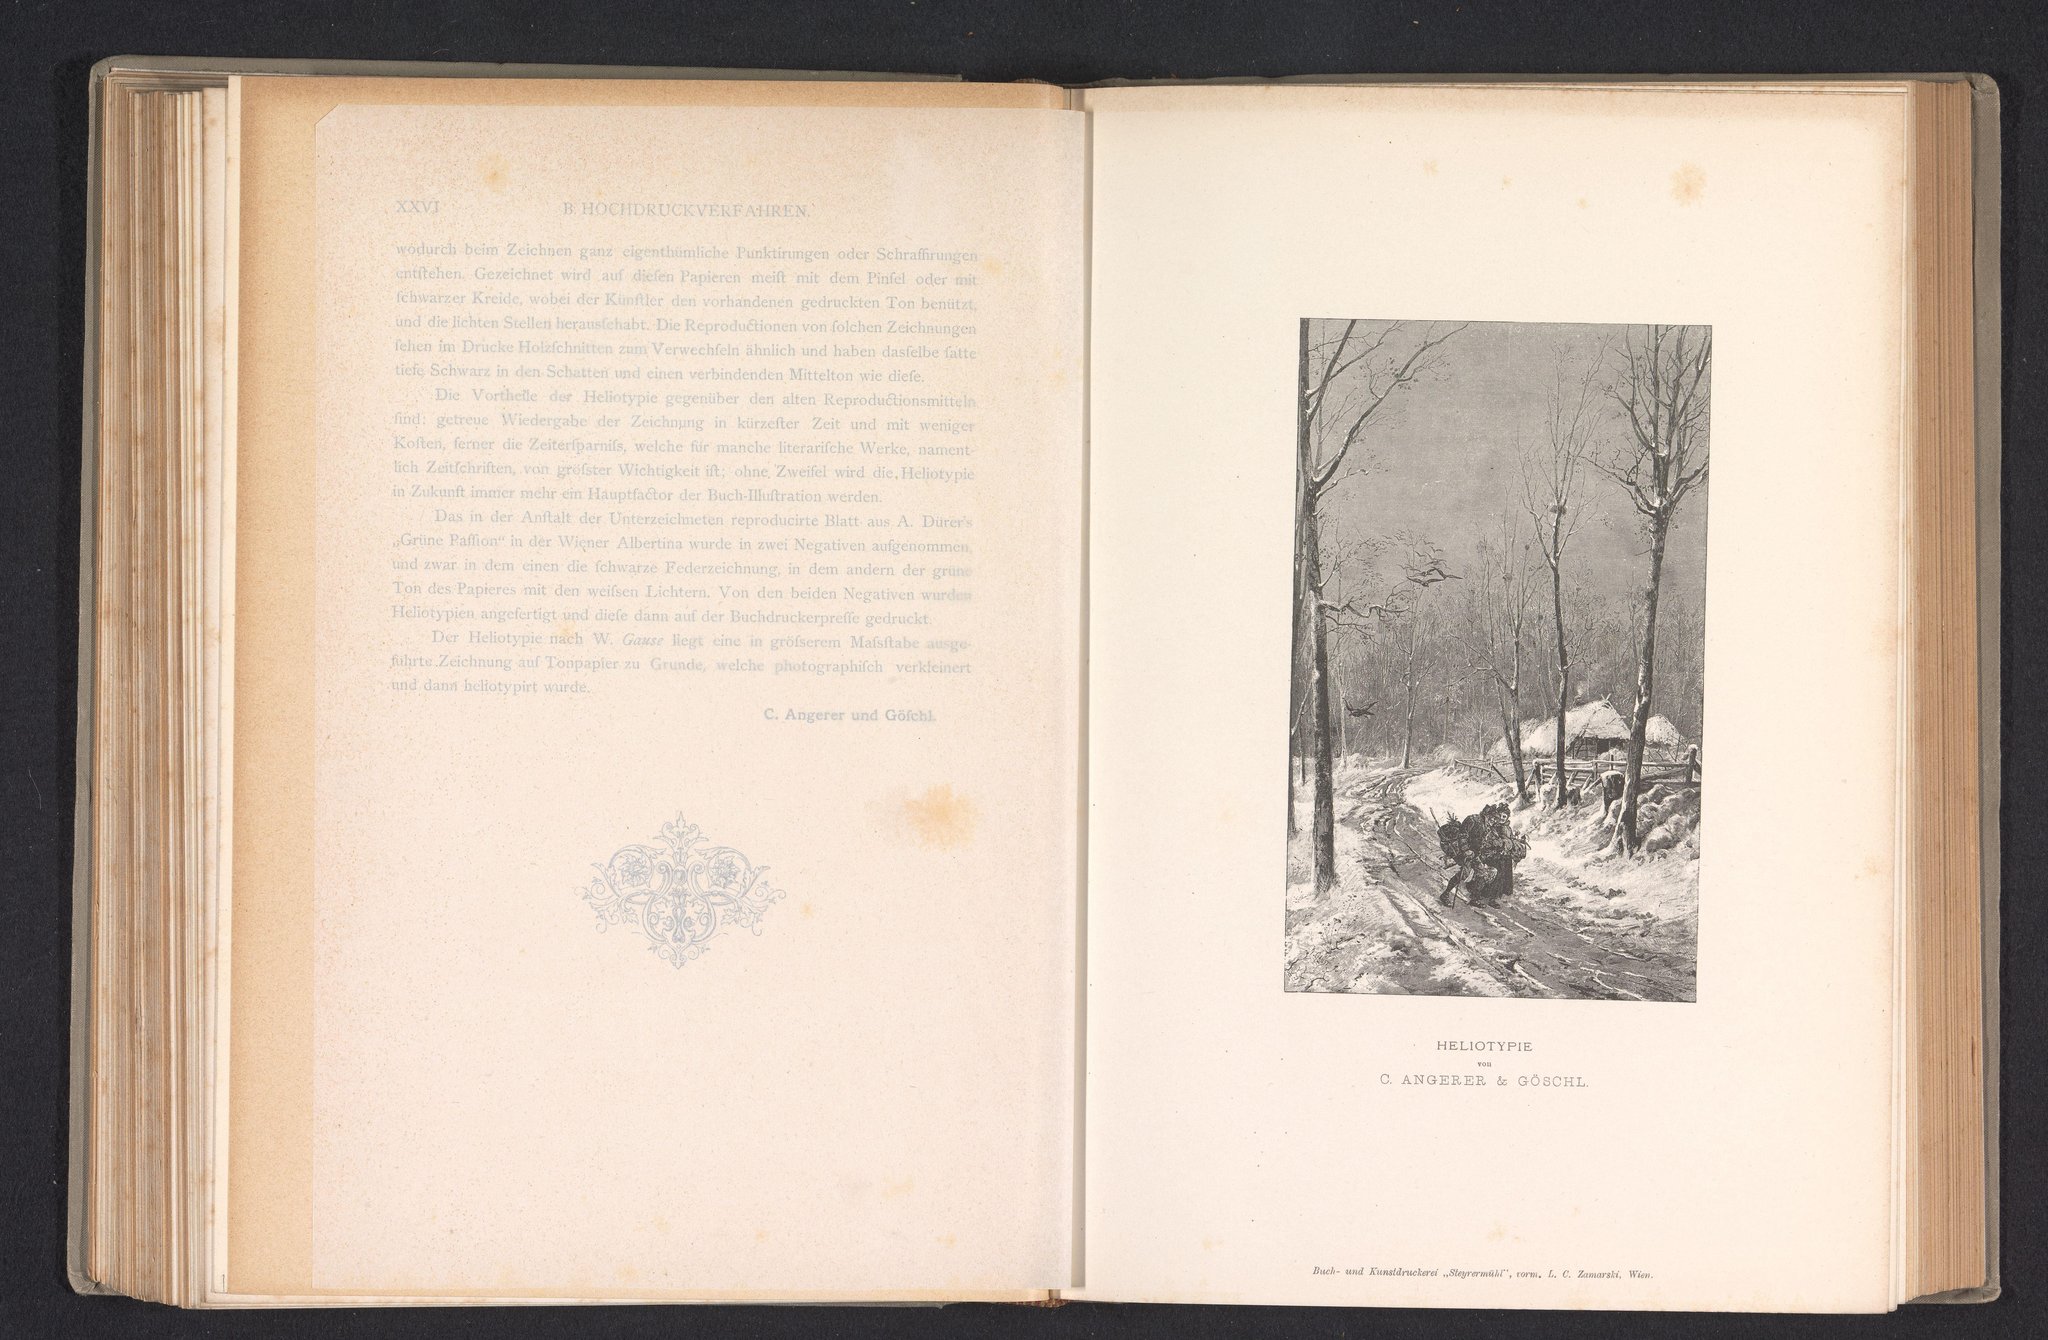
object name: photomechanical print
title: Fotoreproductie van een prent, voorstellende een man en een vrouw op een landweg in een besneeuwd landschap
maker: Anonymous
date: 1880-1883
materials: paper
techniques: photoaquatint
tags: snow, couple of lovers, public road